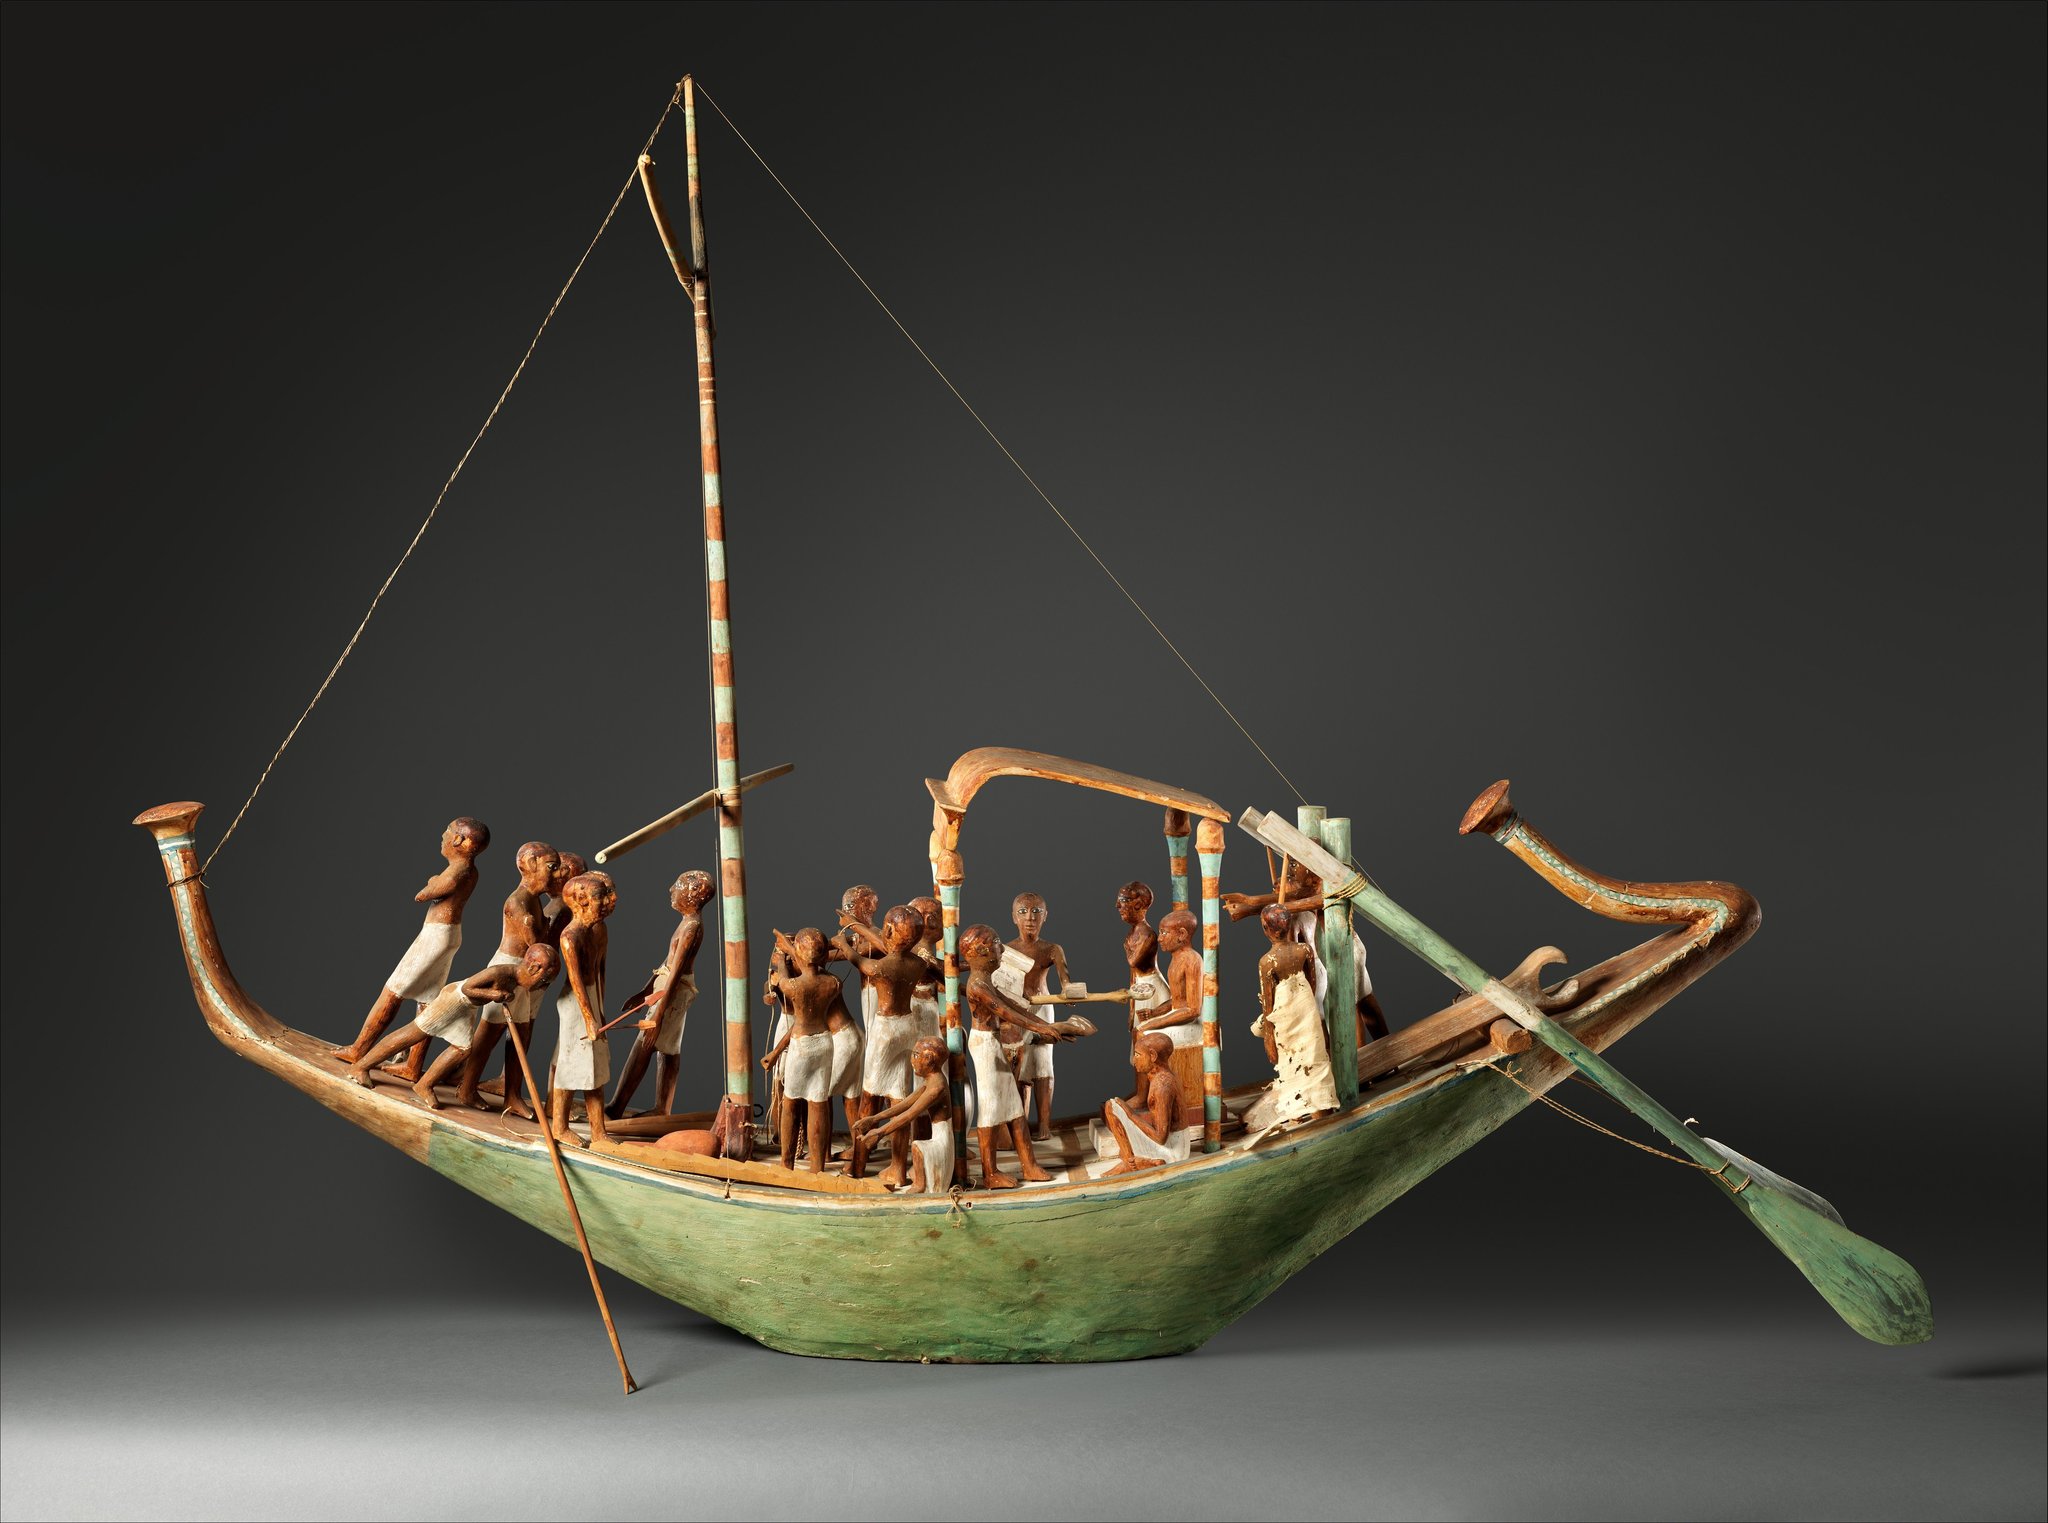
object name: boat, funerary, meketre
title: Model Sailboat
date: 1981-1975 BCE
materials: linen, paint, plaster, wood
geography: egypt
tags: men,boats,meketre-models